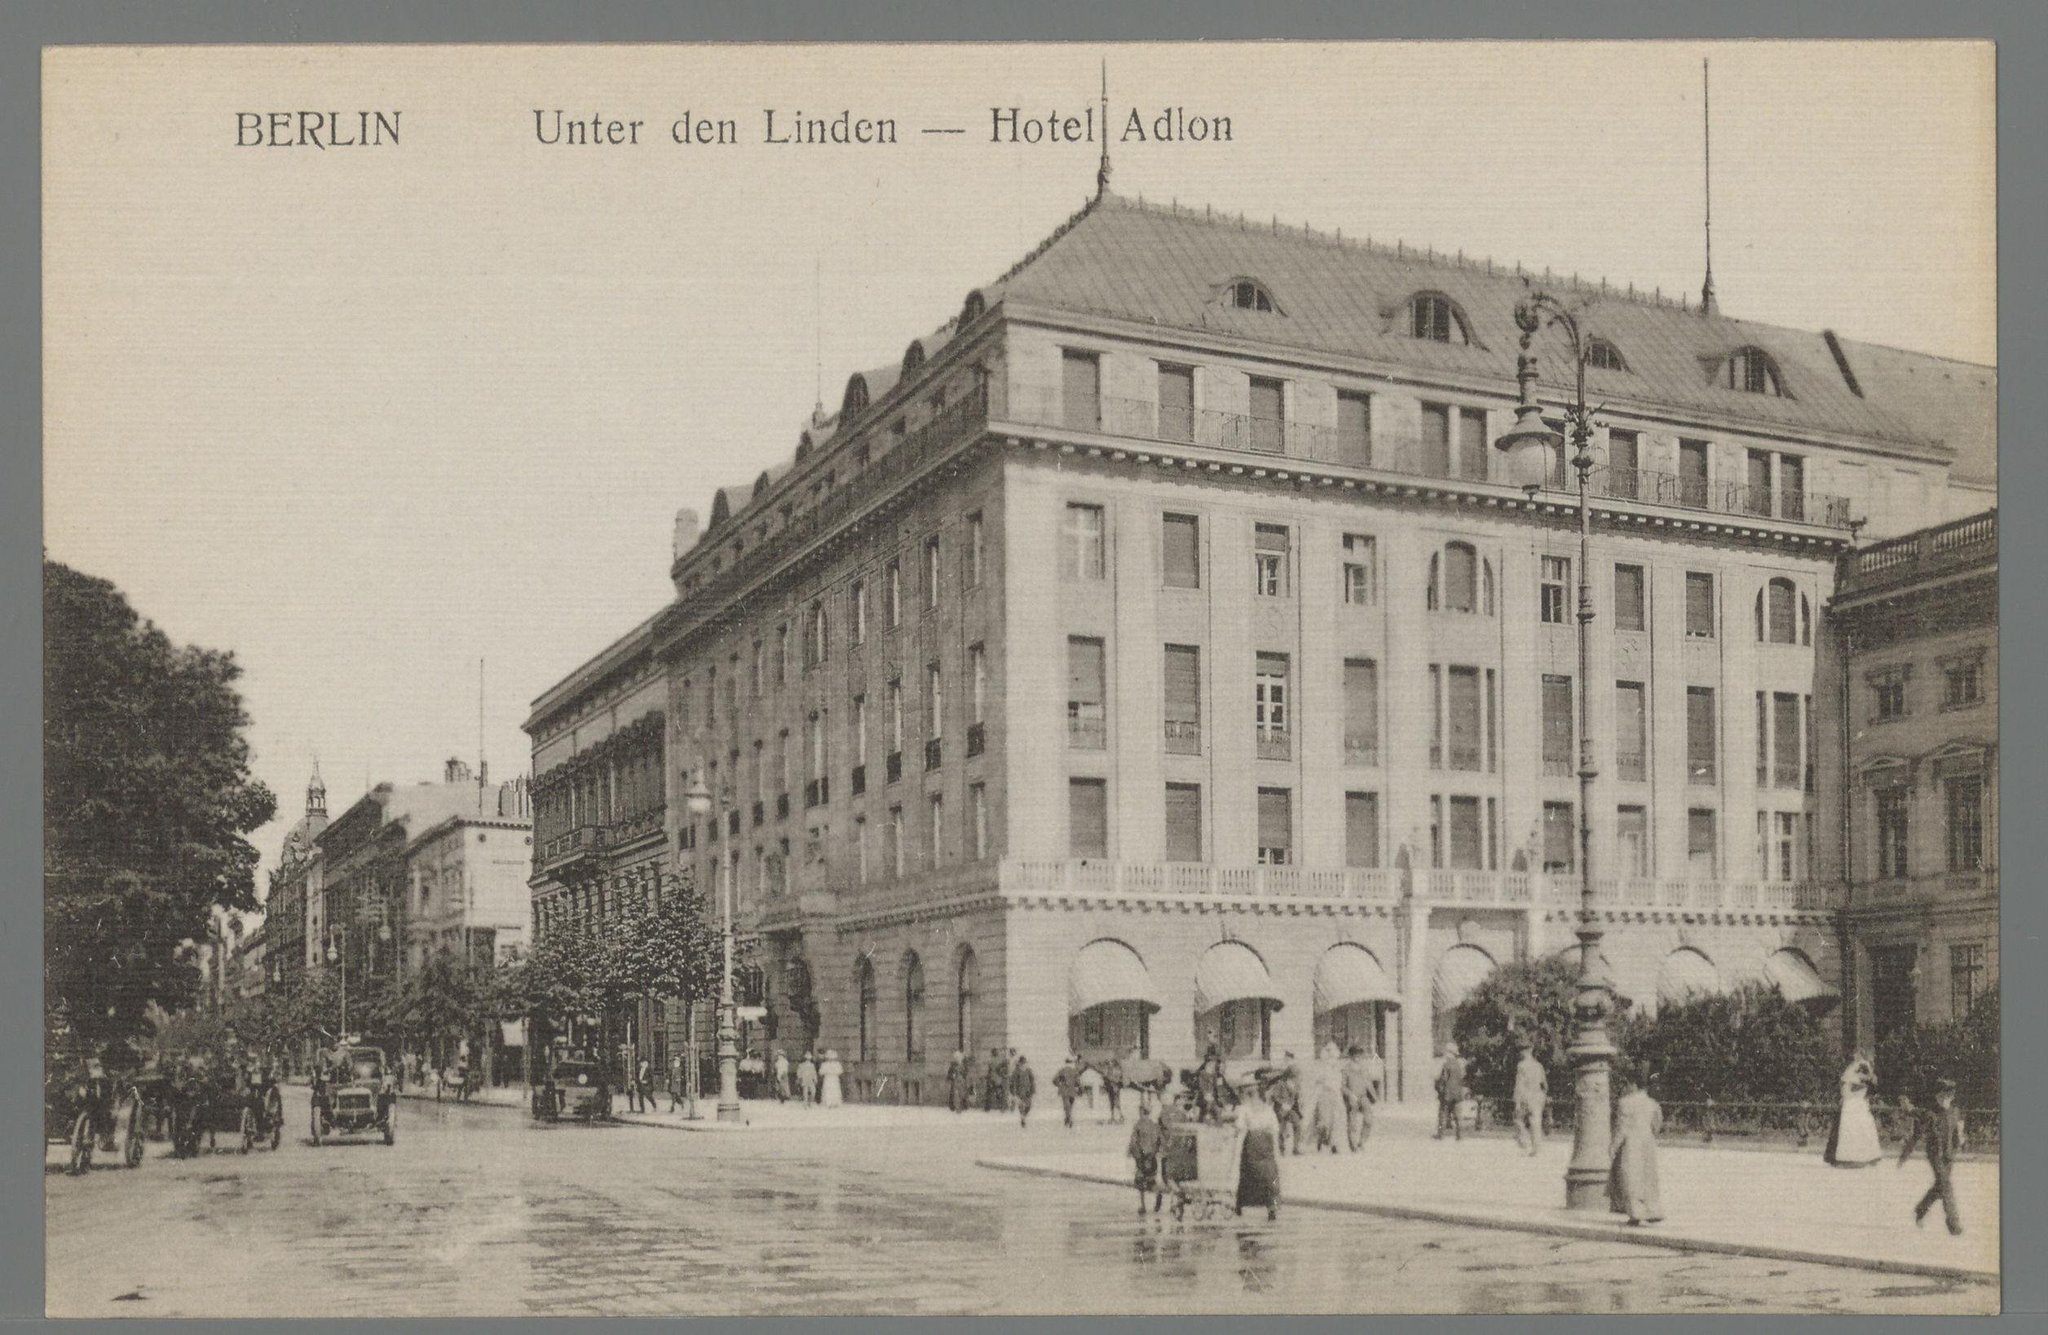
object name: ansichtkaart, prentbriefkaart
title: Berlin. Unter den Linden - Hotel Adlon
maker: Anonymous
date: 1905-1930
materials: cardboard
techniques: photograph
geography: berlin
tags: street, hotel, hostelry, inn